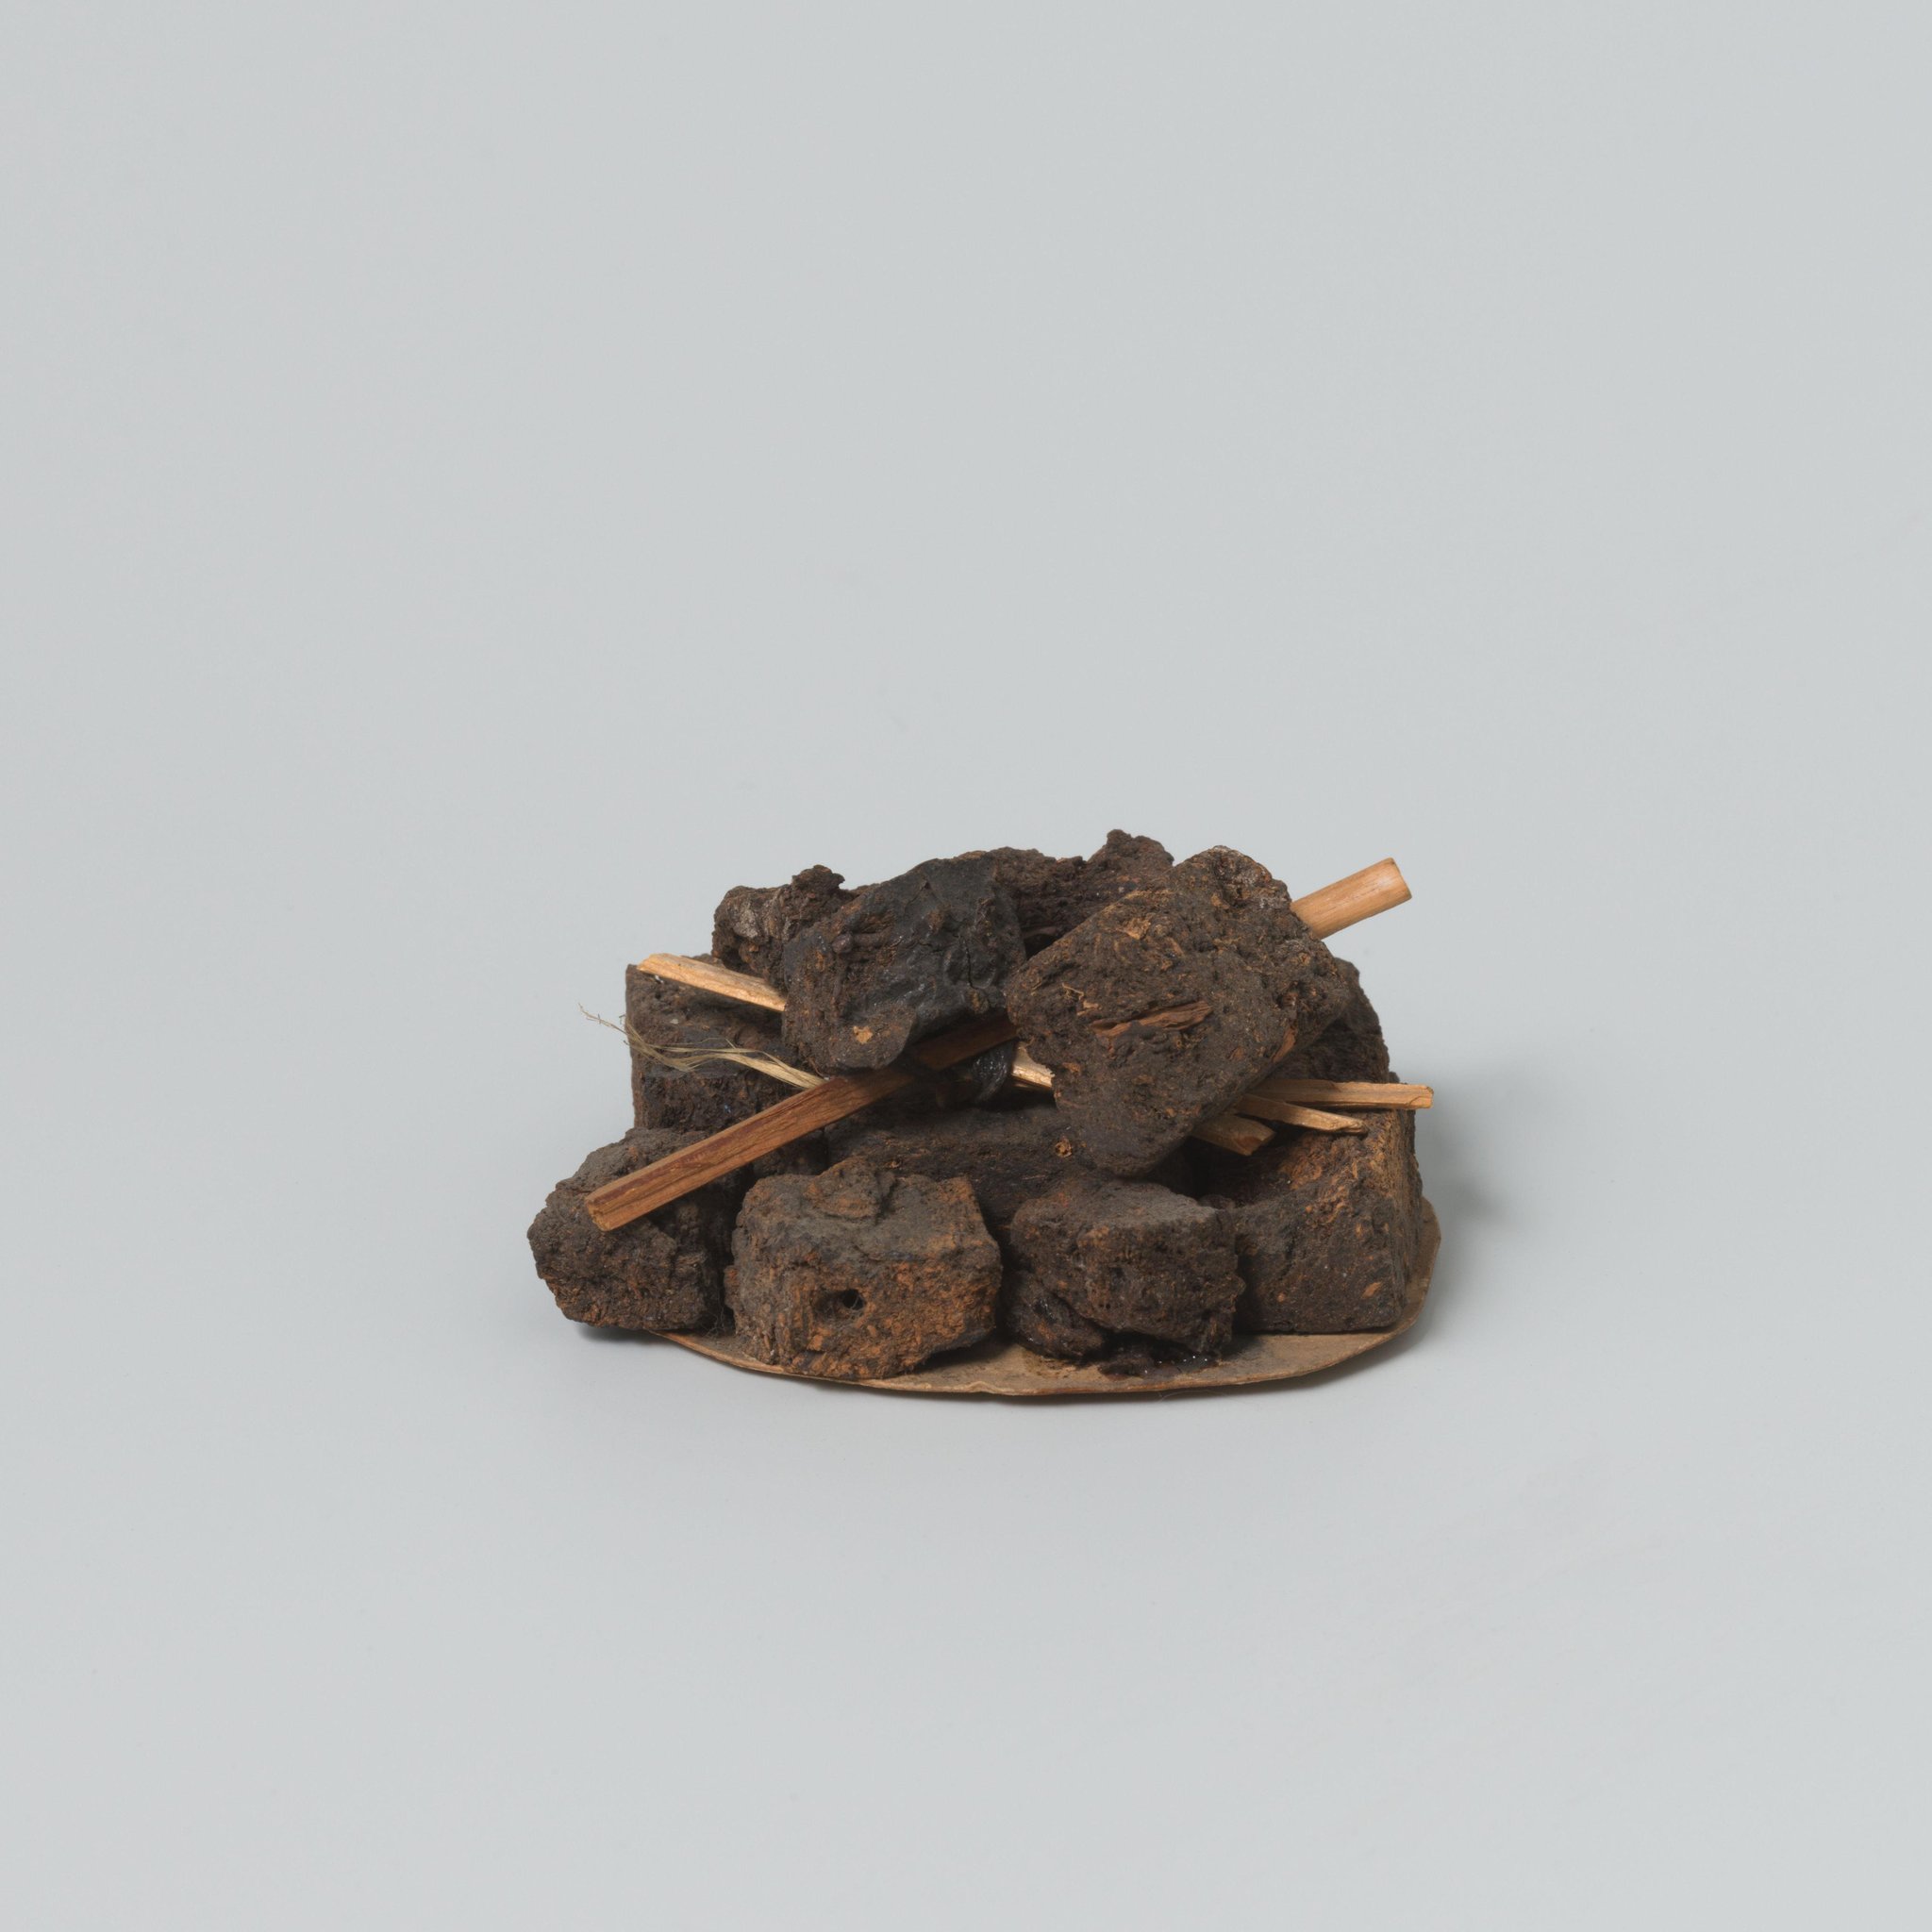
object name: miniature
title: Turfblokken, opgestapeld op een stuk papier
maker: Anonymous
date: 1676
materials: paper, peat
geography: amsterdam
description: Turfblokken, opgestapeld op een stuk papier (deel van een speelkaart).